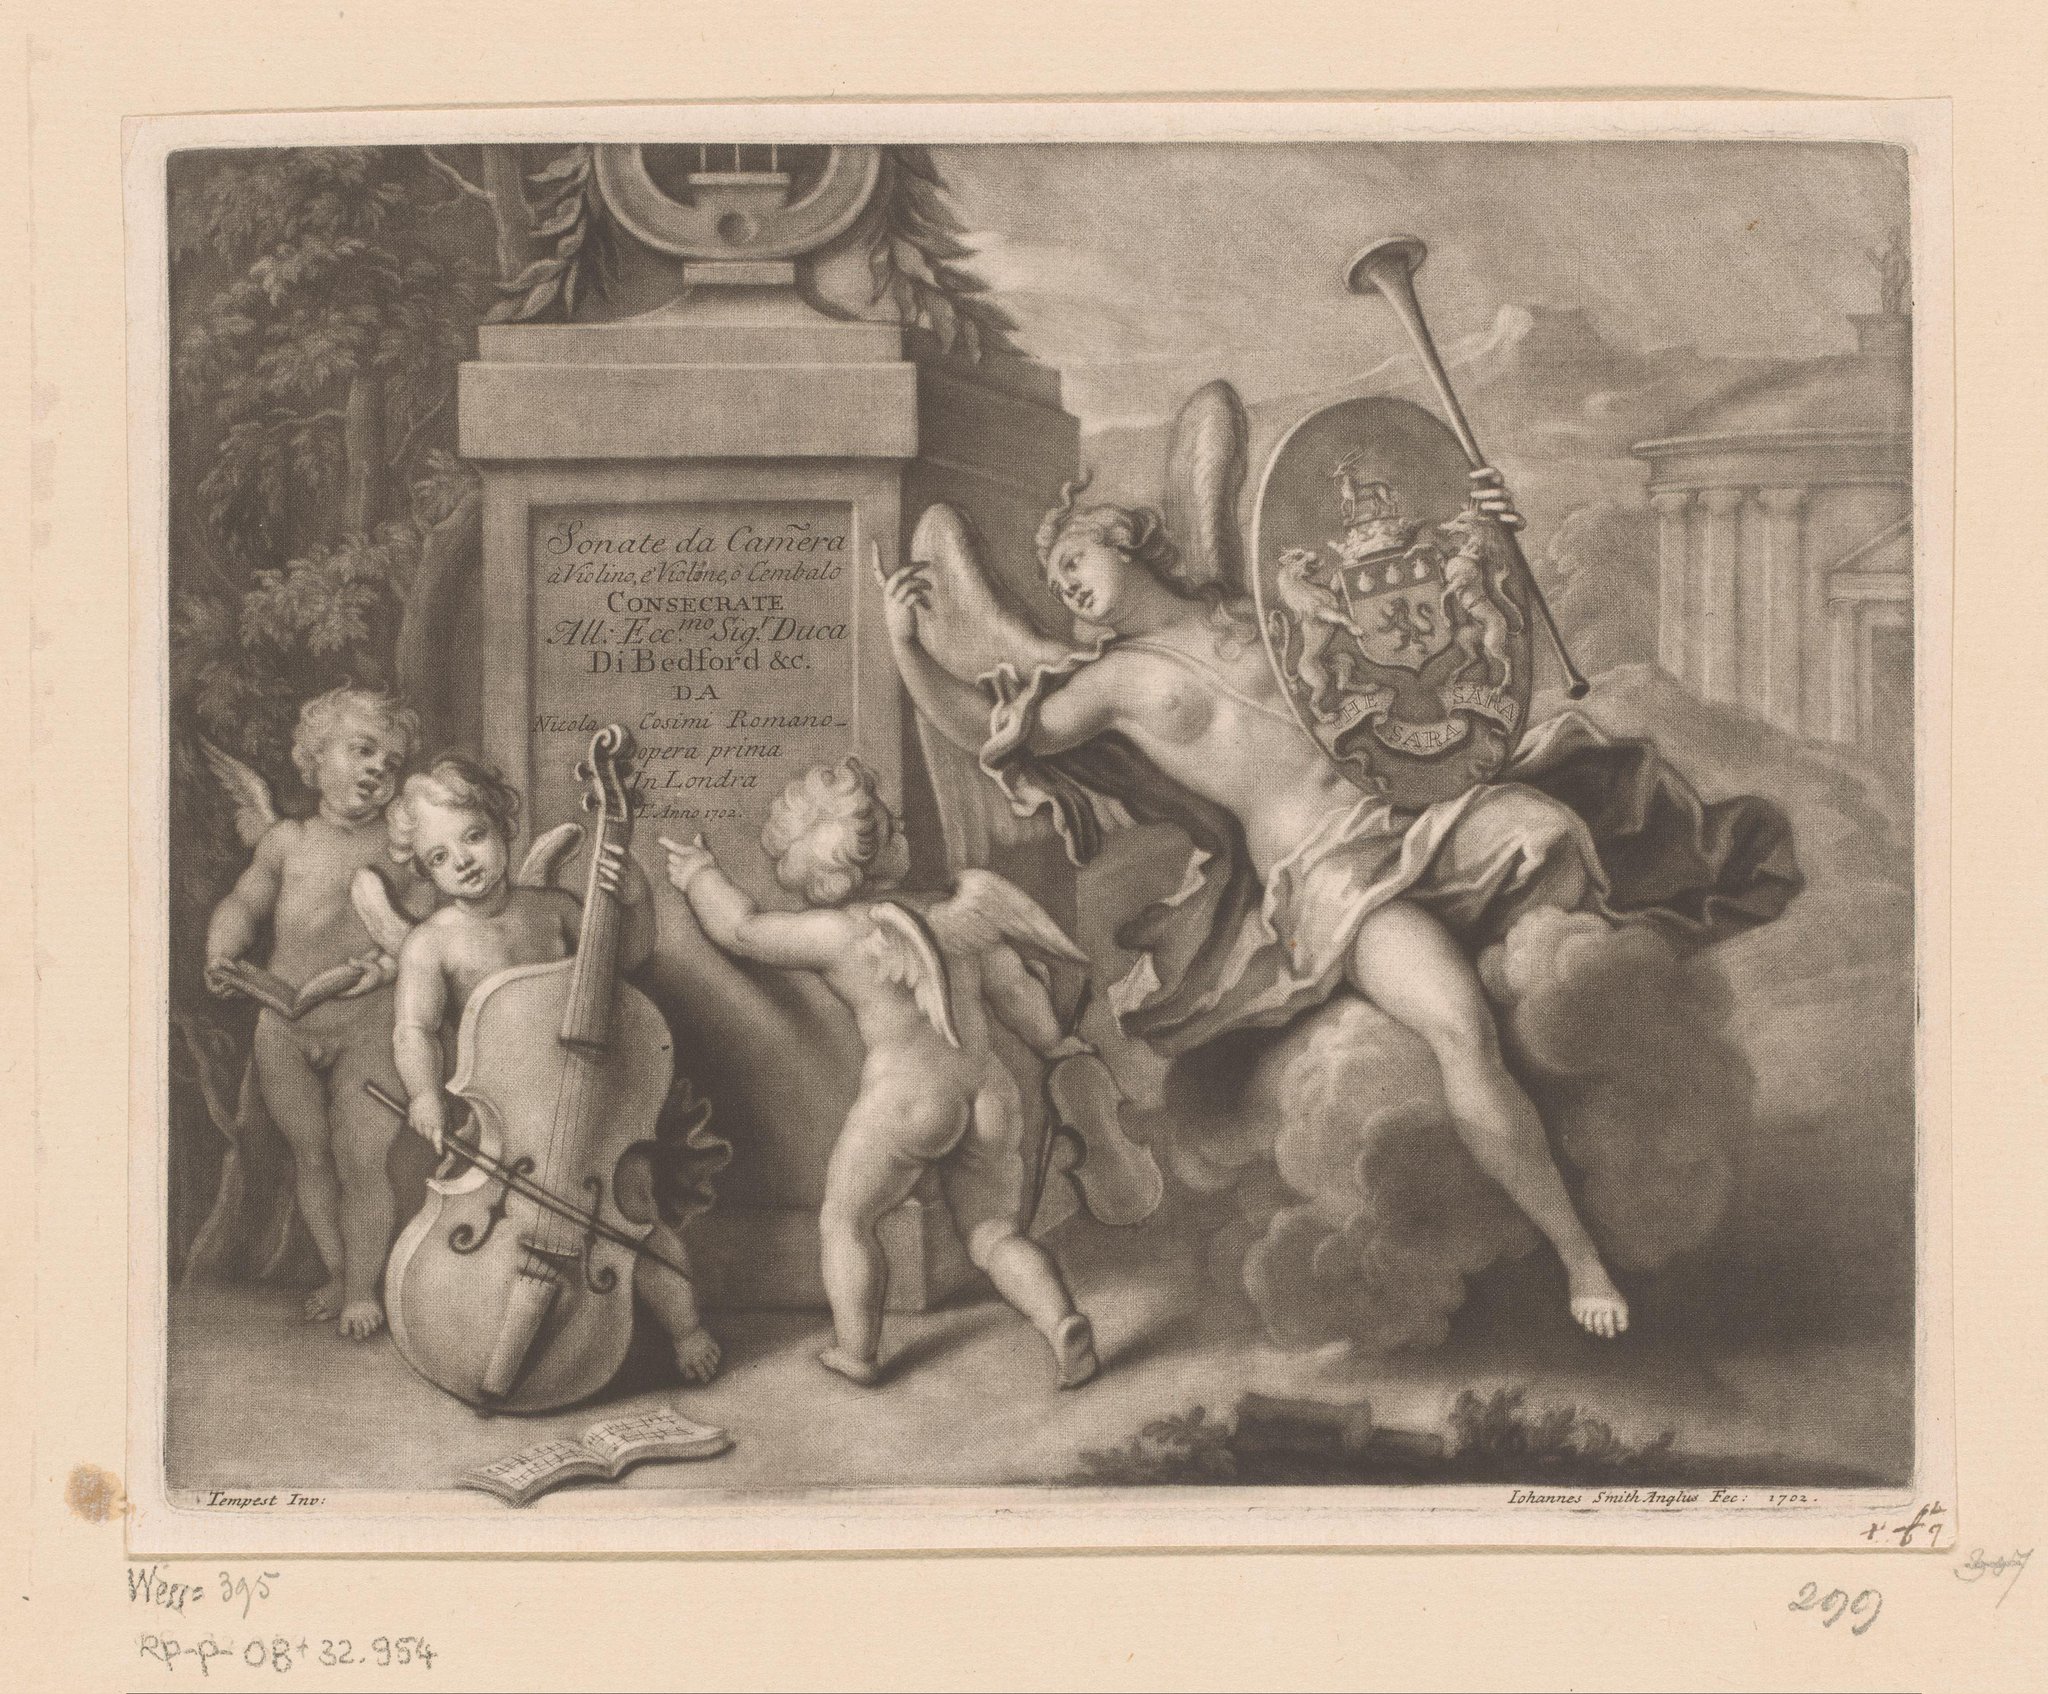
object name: print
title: Engelen met muziekinstrumenten bij een monument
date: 1702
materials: paper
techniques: mezzotint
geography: england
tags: monument, statue, cupids: 'amores', 'amoretti', 'putti'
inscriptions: collector's mark: Lugt 240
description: Het plakkaat op het monument bevat de tekst 'Sonate da camera a violino e violone o cemba' uit een muziekstuk door Nicola Cosimi (1667-1717).